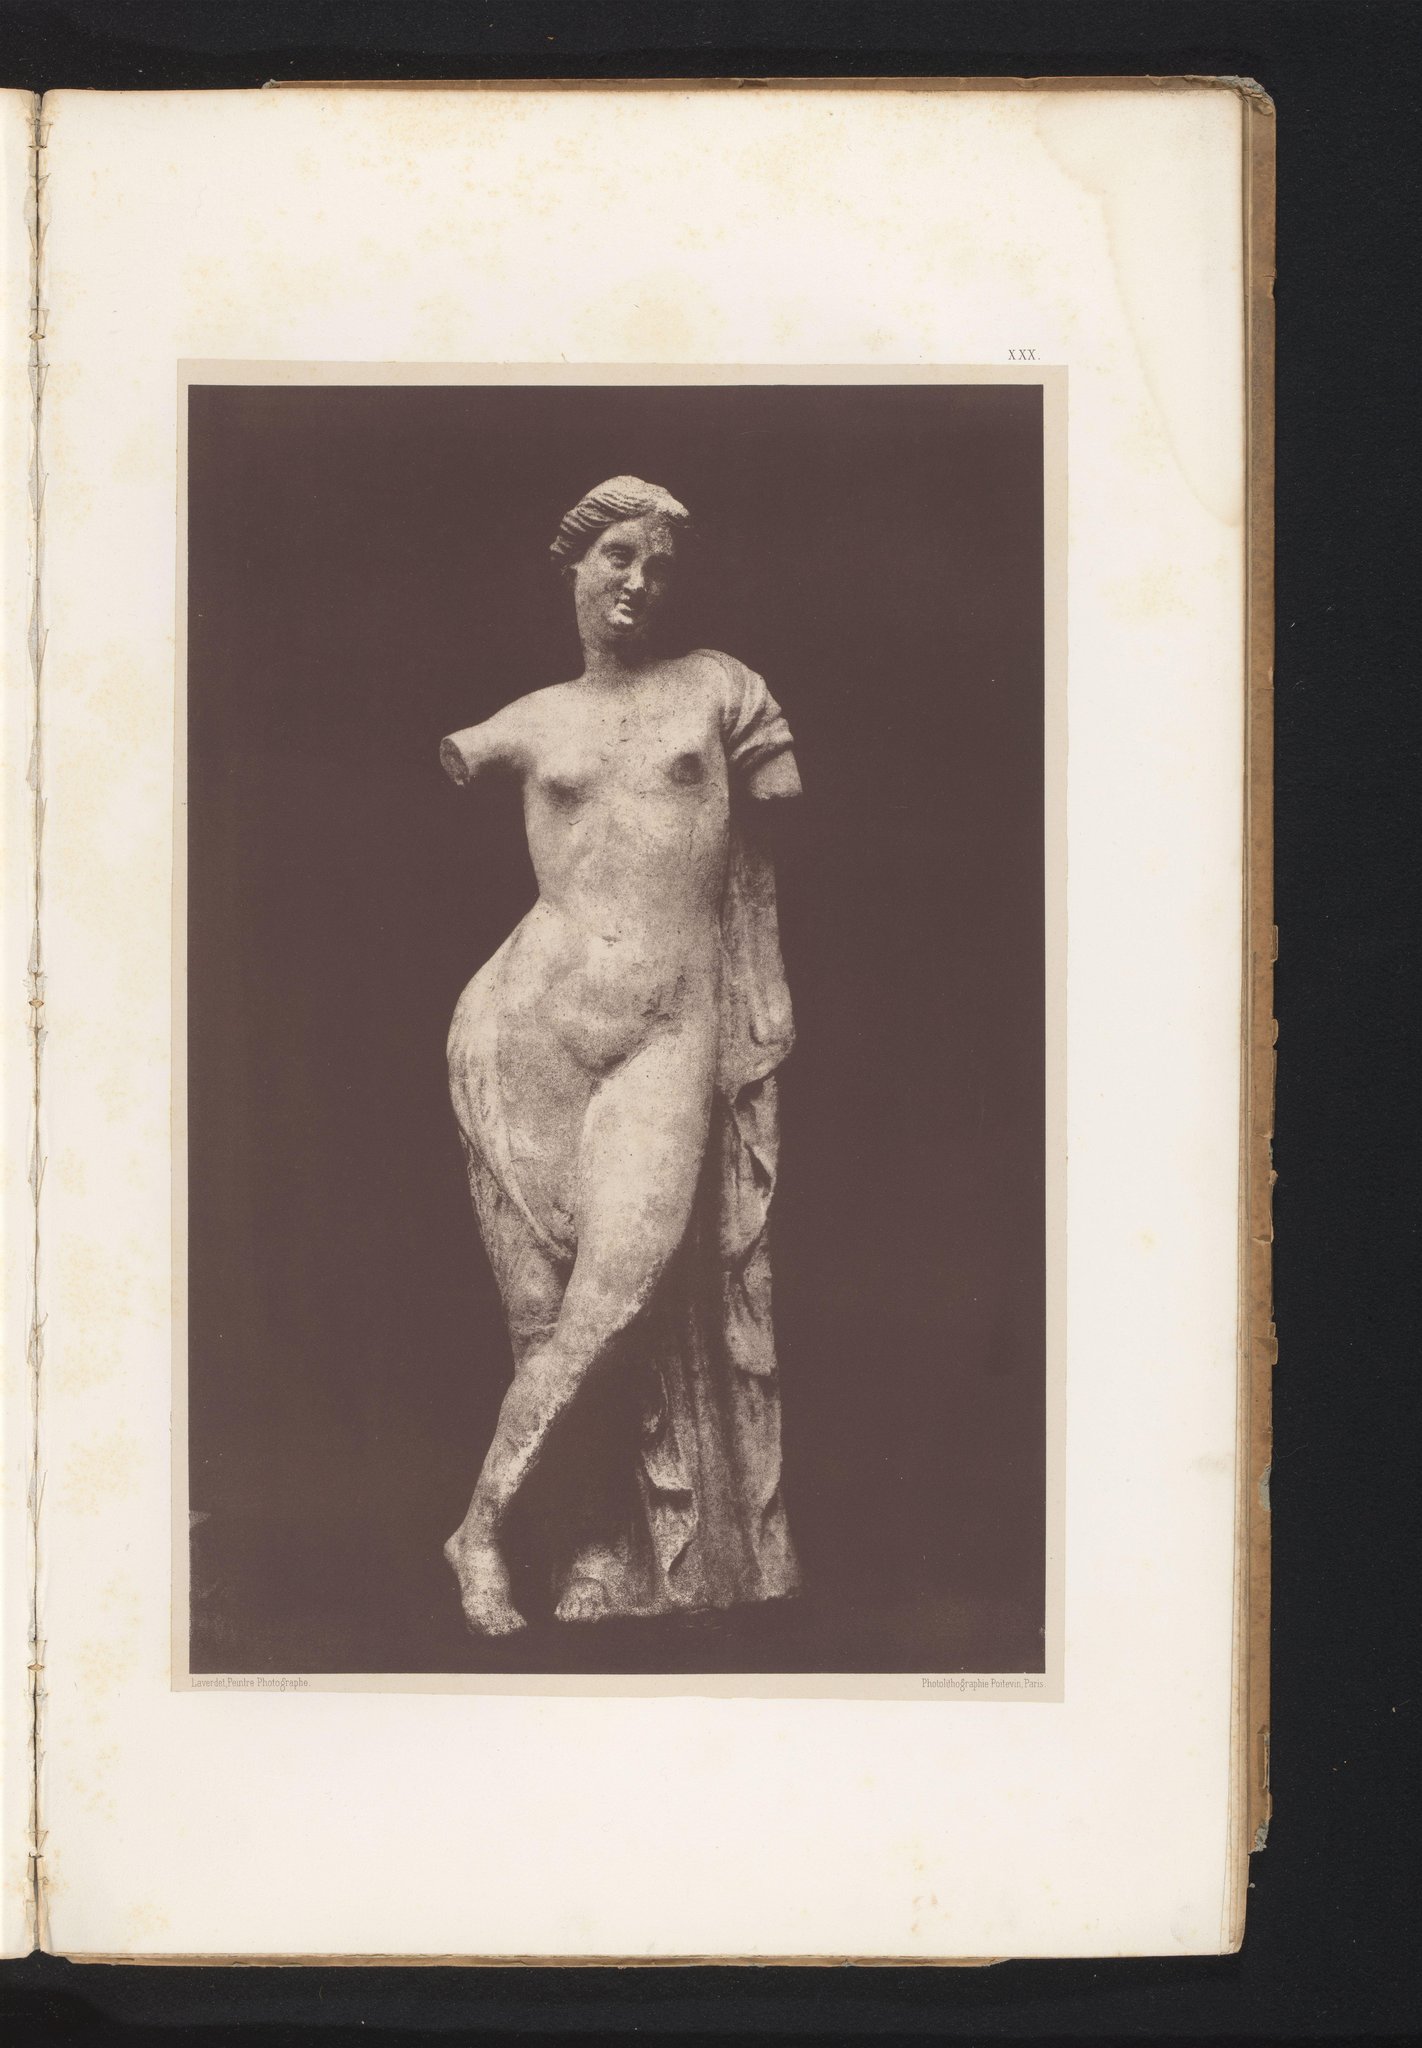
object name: photomechanical print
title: Terracotta sculptuur van Venus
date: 1852-1857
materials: paper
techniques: photolithography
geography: paris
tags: piece of sculpture, reproduction of a piece of sculpture (+ clay, sand, etc. ~ arts), (story of) venus (aphrodite)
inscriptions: number: ‘XXX.’